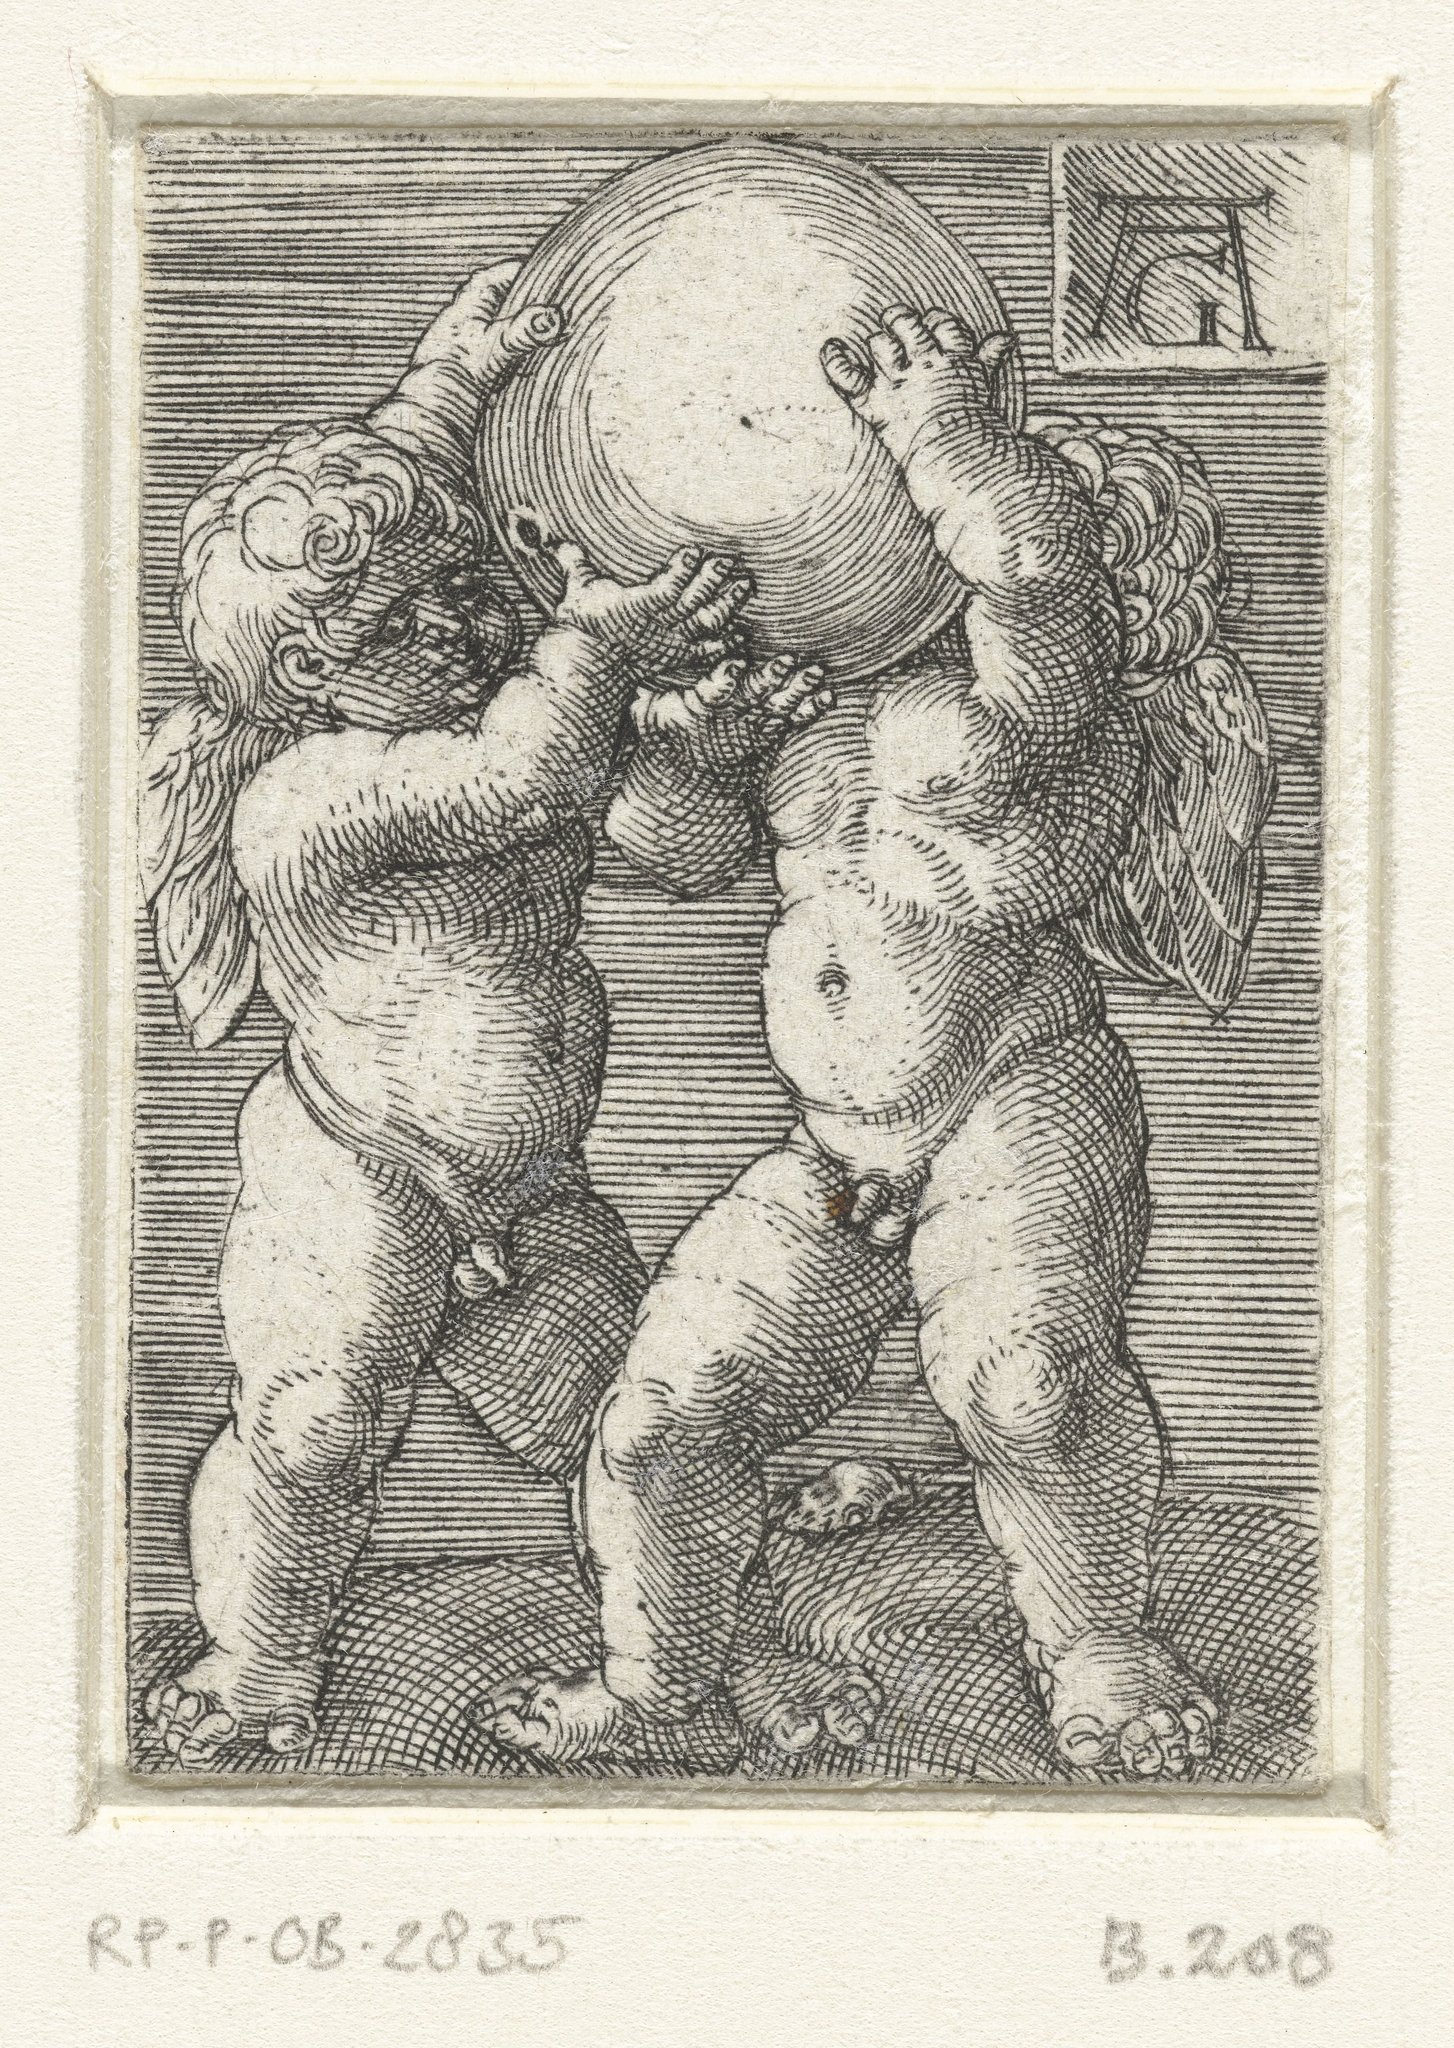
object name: ornament print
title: Twee putti die een bol dragen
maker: heinrich aldegrever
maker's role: draughtsman, print maker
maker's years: 1502-1561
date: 1512-1560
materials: paper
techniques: engraving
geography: germany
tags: ornaments ~ art, cupids: 'amores', 'amoretti', 'putti'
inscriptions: number: ‘11’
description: Vlakdecoratie met twee putti die een bol omhoog houden.